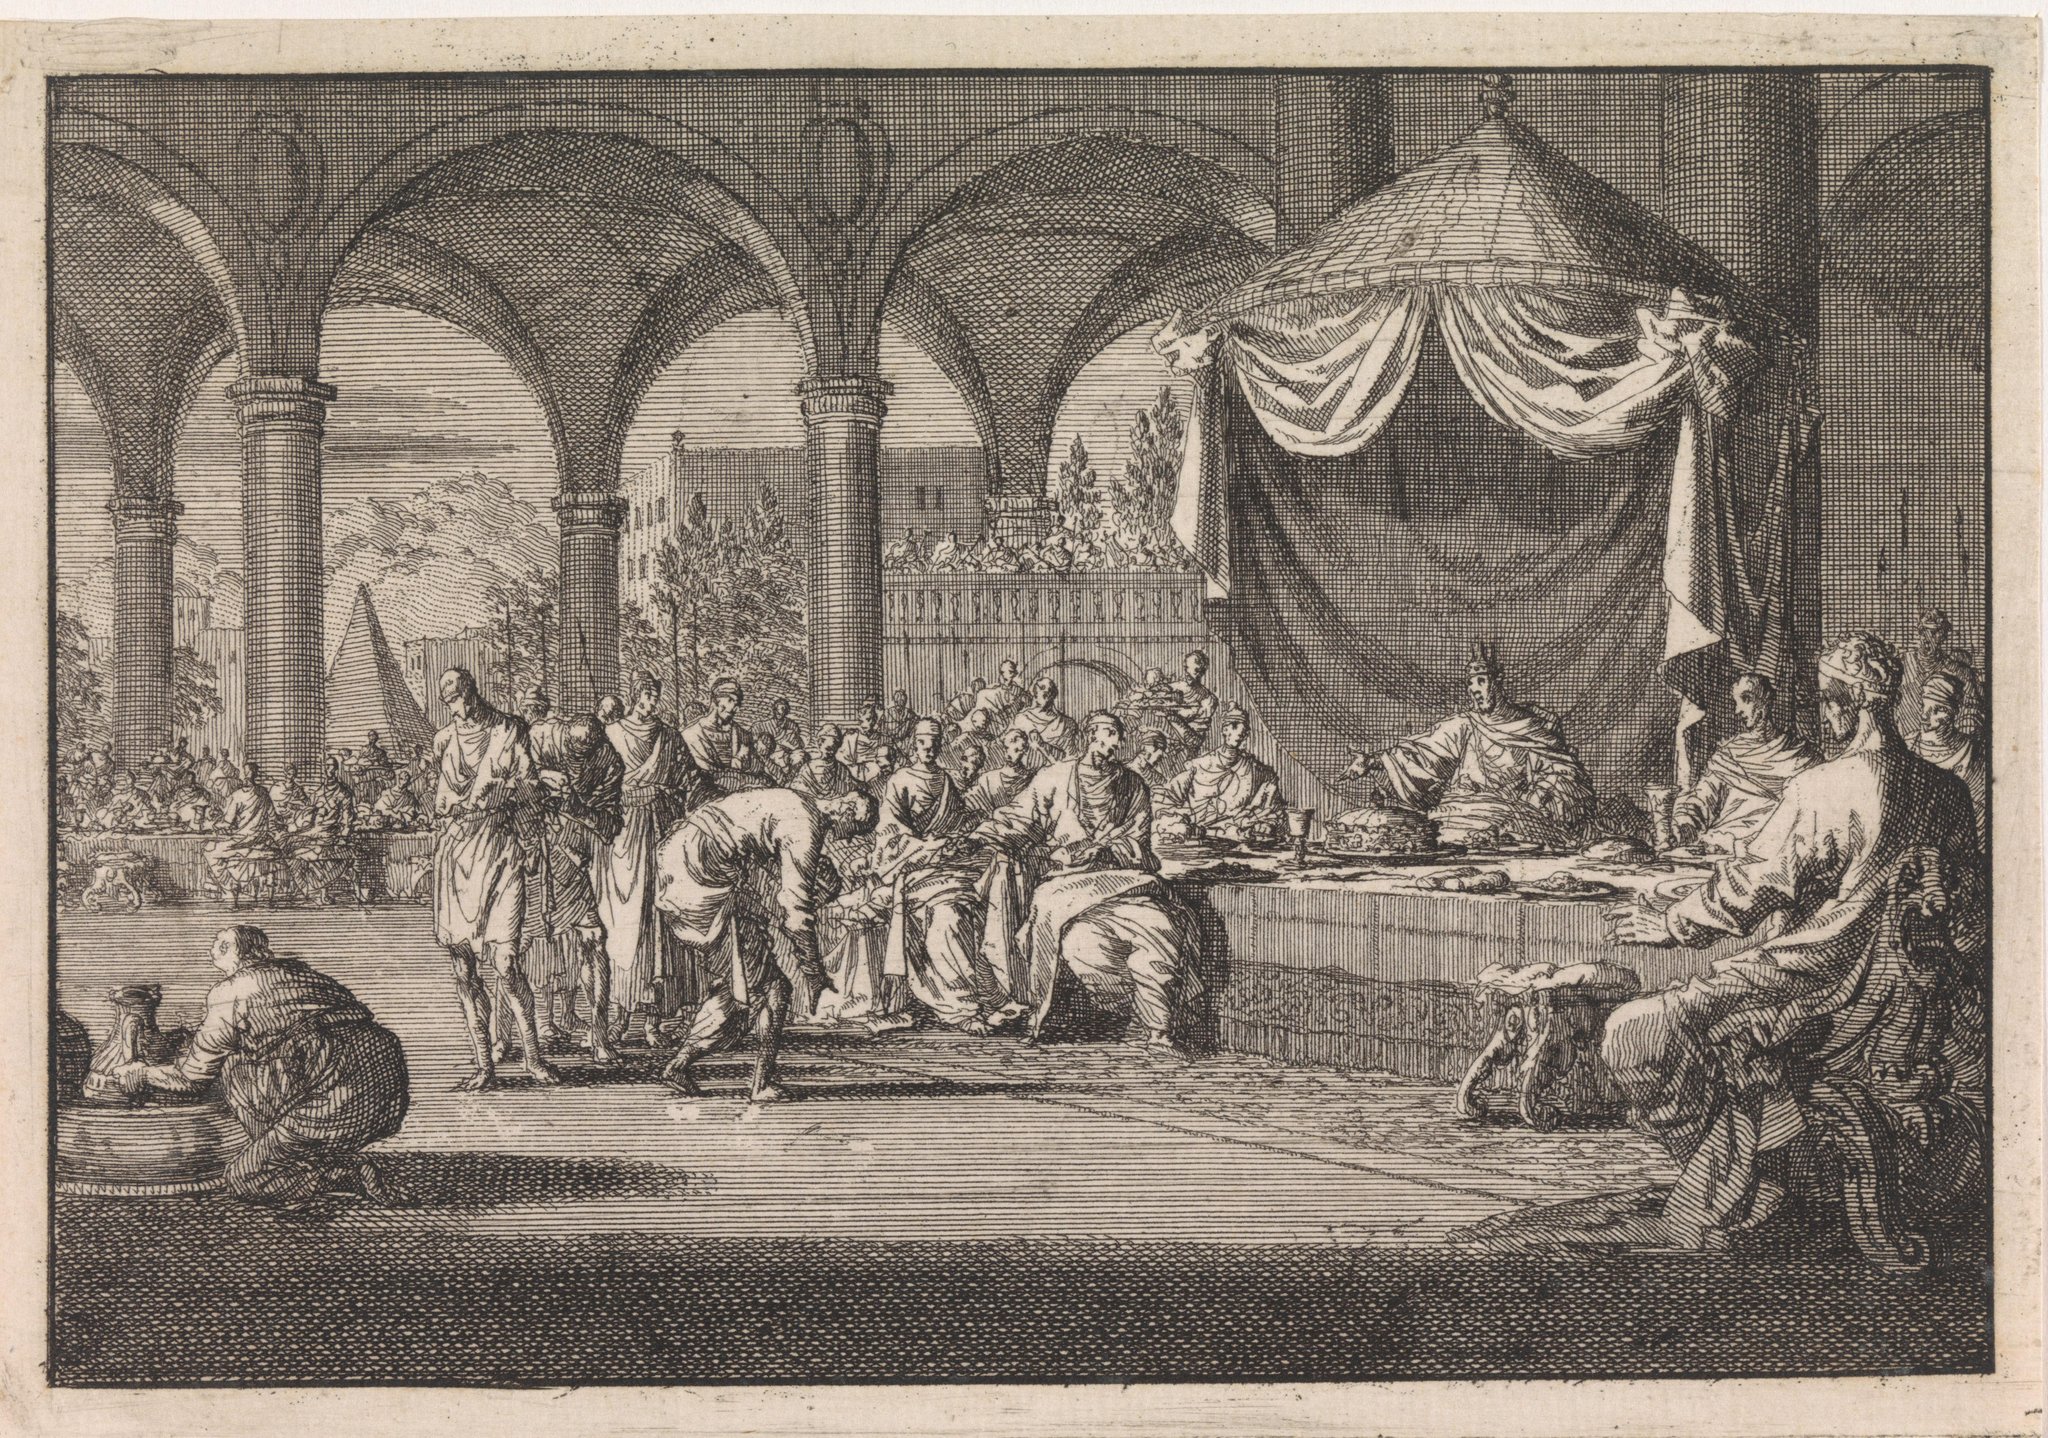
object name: print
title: Eerherstel van de wijnschenker van de farao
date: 1703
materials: paper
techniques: etching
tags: the fulfilment of the dreams: pharaoh restores the butler to his former position, but has the baker hanged ~ story of joseph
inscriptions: collector's mark: Lugt 2228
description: Proefdruk van een boekillustratie voor David Martin. Historie des Ouden en Nieuwen Testaments. Amsterdam, Pieter Mortier, 1703. Deel I. De boekillustraties voor de Mortierbijbel hebben verschillende staten en kopieën, waarbij de chronologische volgorde moeilijk te achterhalen valt. Als boekillustraties werden ze bovendien herhaaldelijk opnieuw gebruikt voor andere boekwerken.